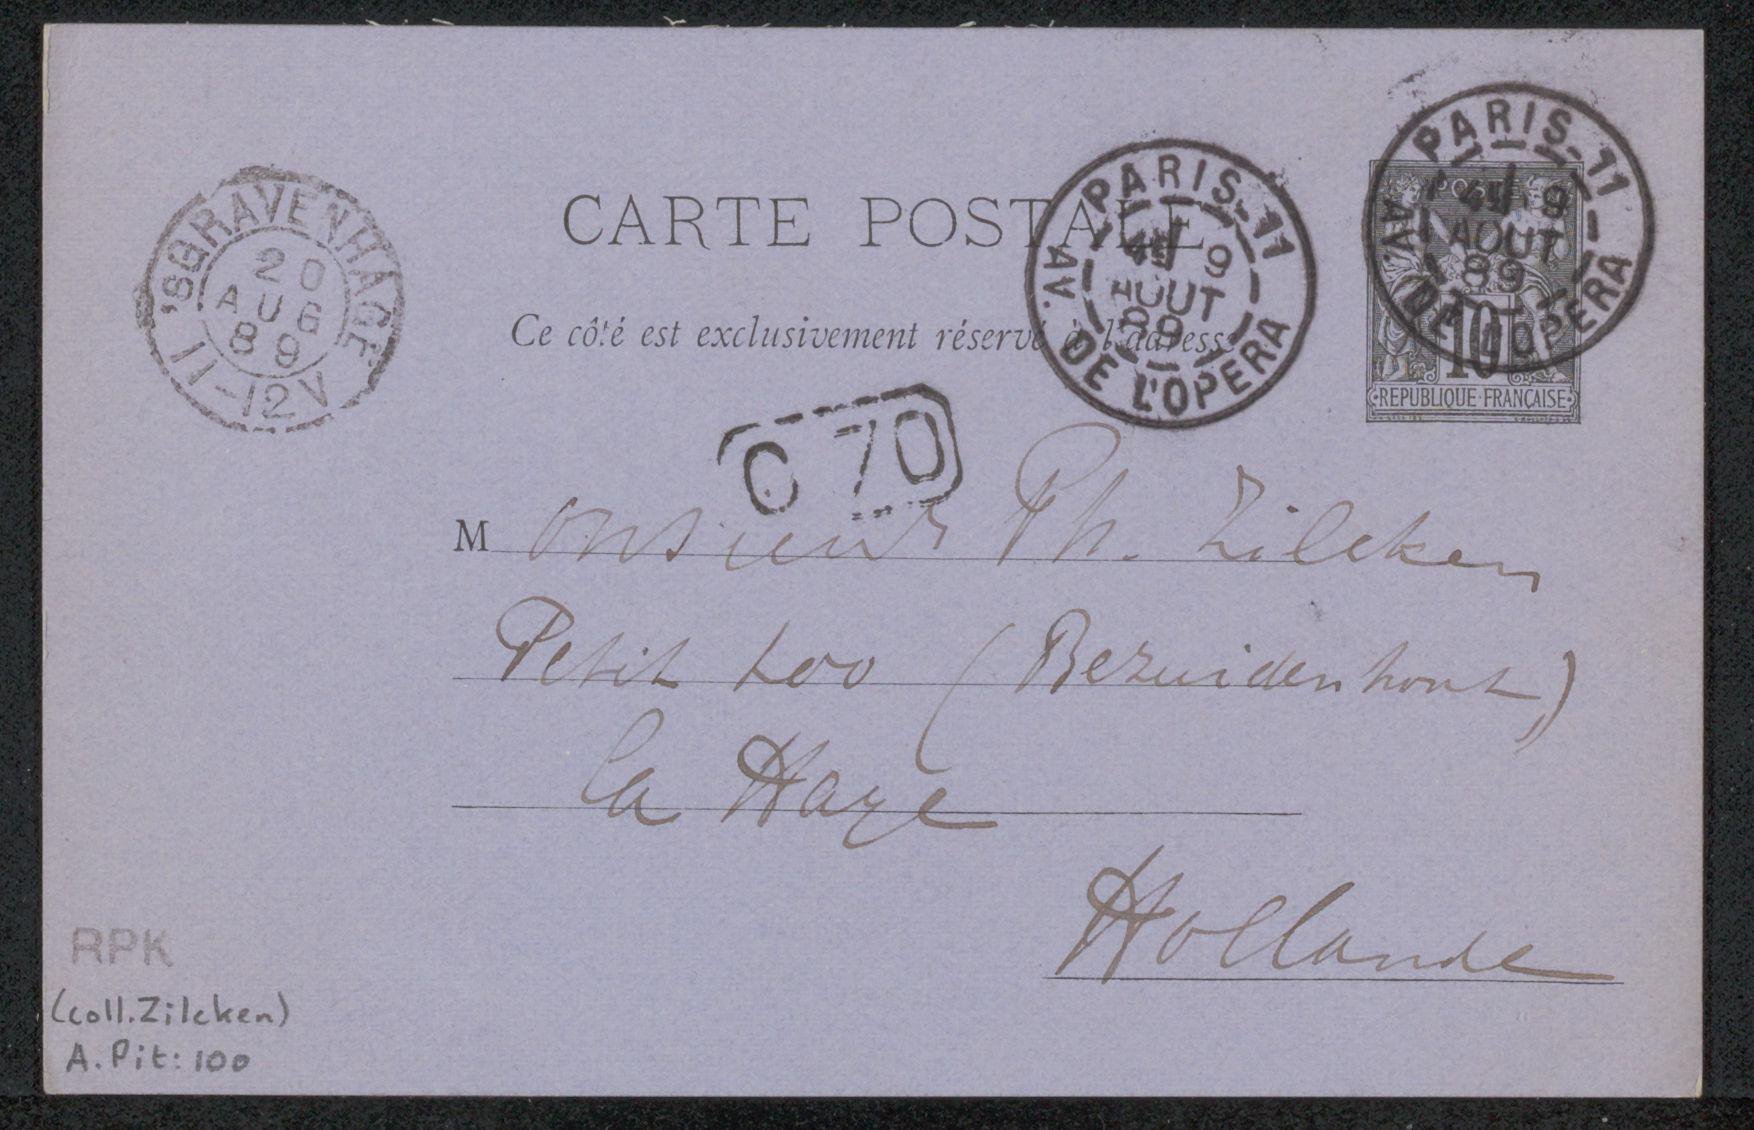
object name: postcard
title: Briefkaart aan Philip Zilcken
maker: adriaan pit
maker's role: print maker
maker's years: 1860-1944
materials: cardboard, ink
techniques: pen, writing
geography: paris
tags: albert besnard, the hague, painter, draughtsman, philip zilcken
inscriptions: collector's mark: ‘RPK’